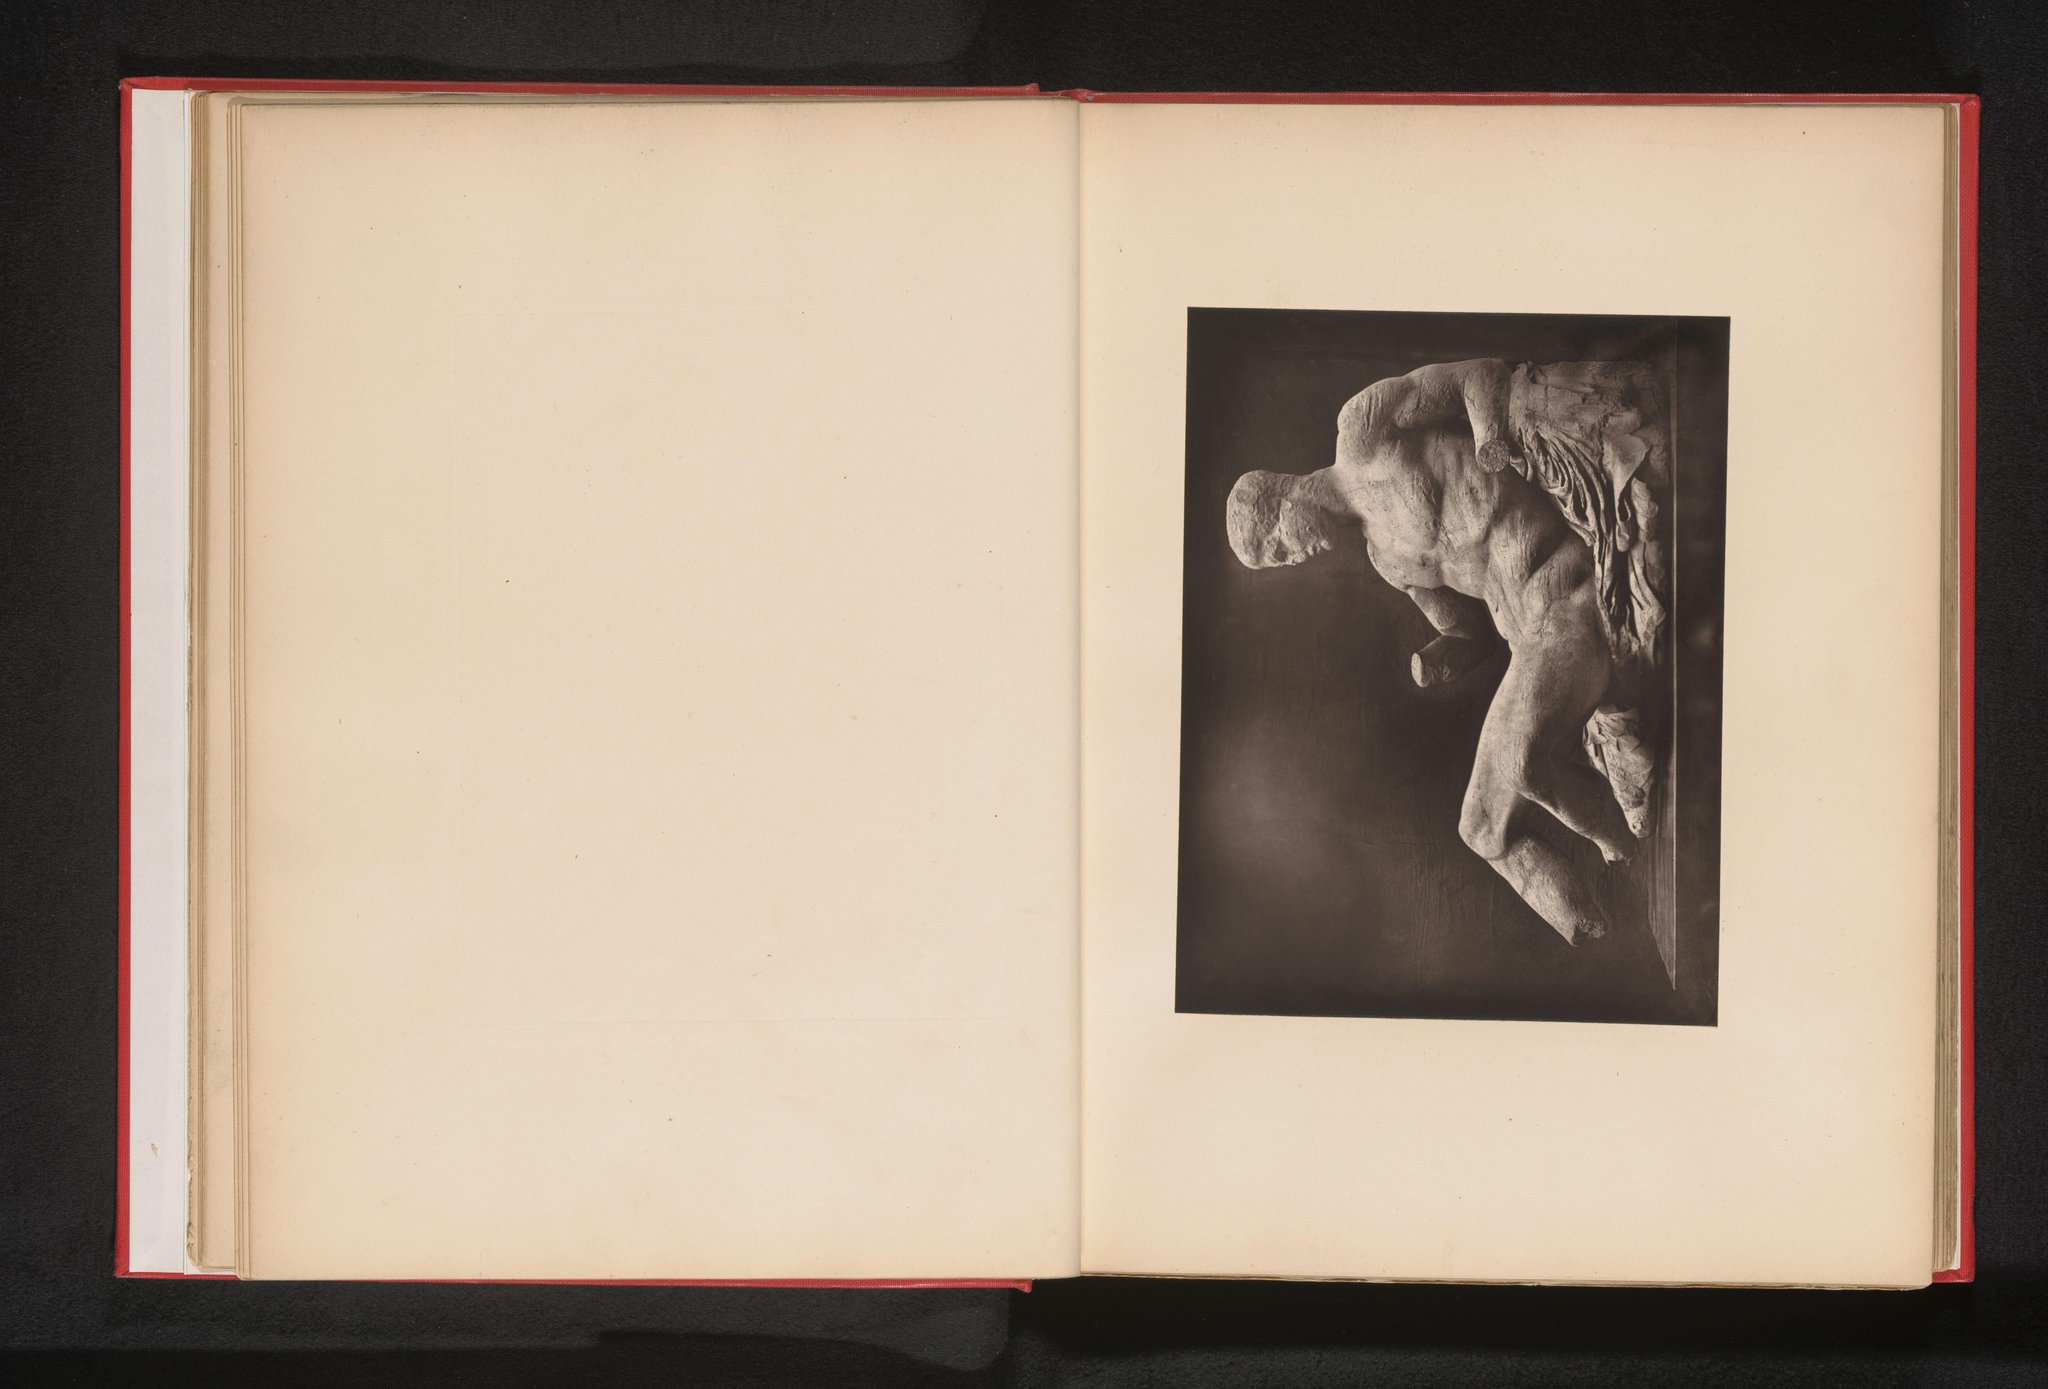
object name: page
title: Sculptuur van Theseus door Phidias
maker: stephen thompson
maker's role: fotograaf, schrijver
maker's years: 1831-1893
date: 1873-1878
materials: paper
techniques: woodburytype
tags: sculpture, (story of) theseus